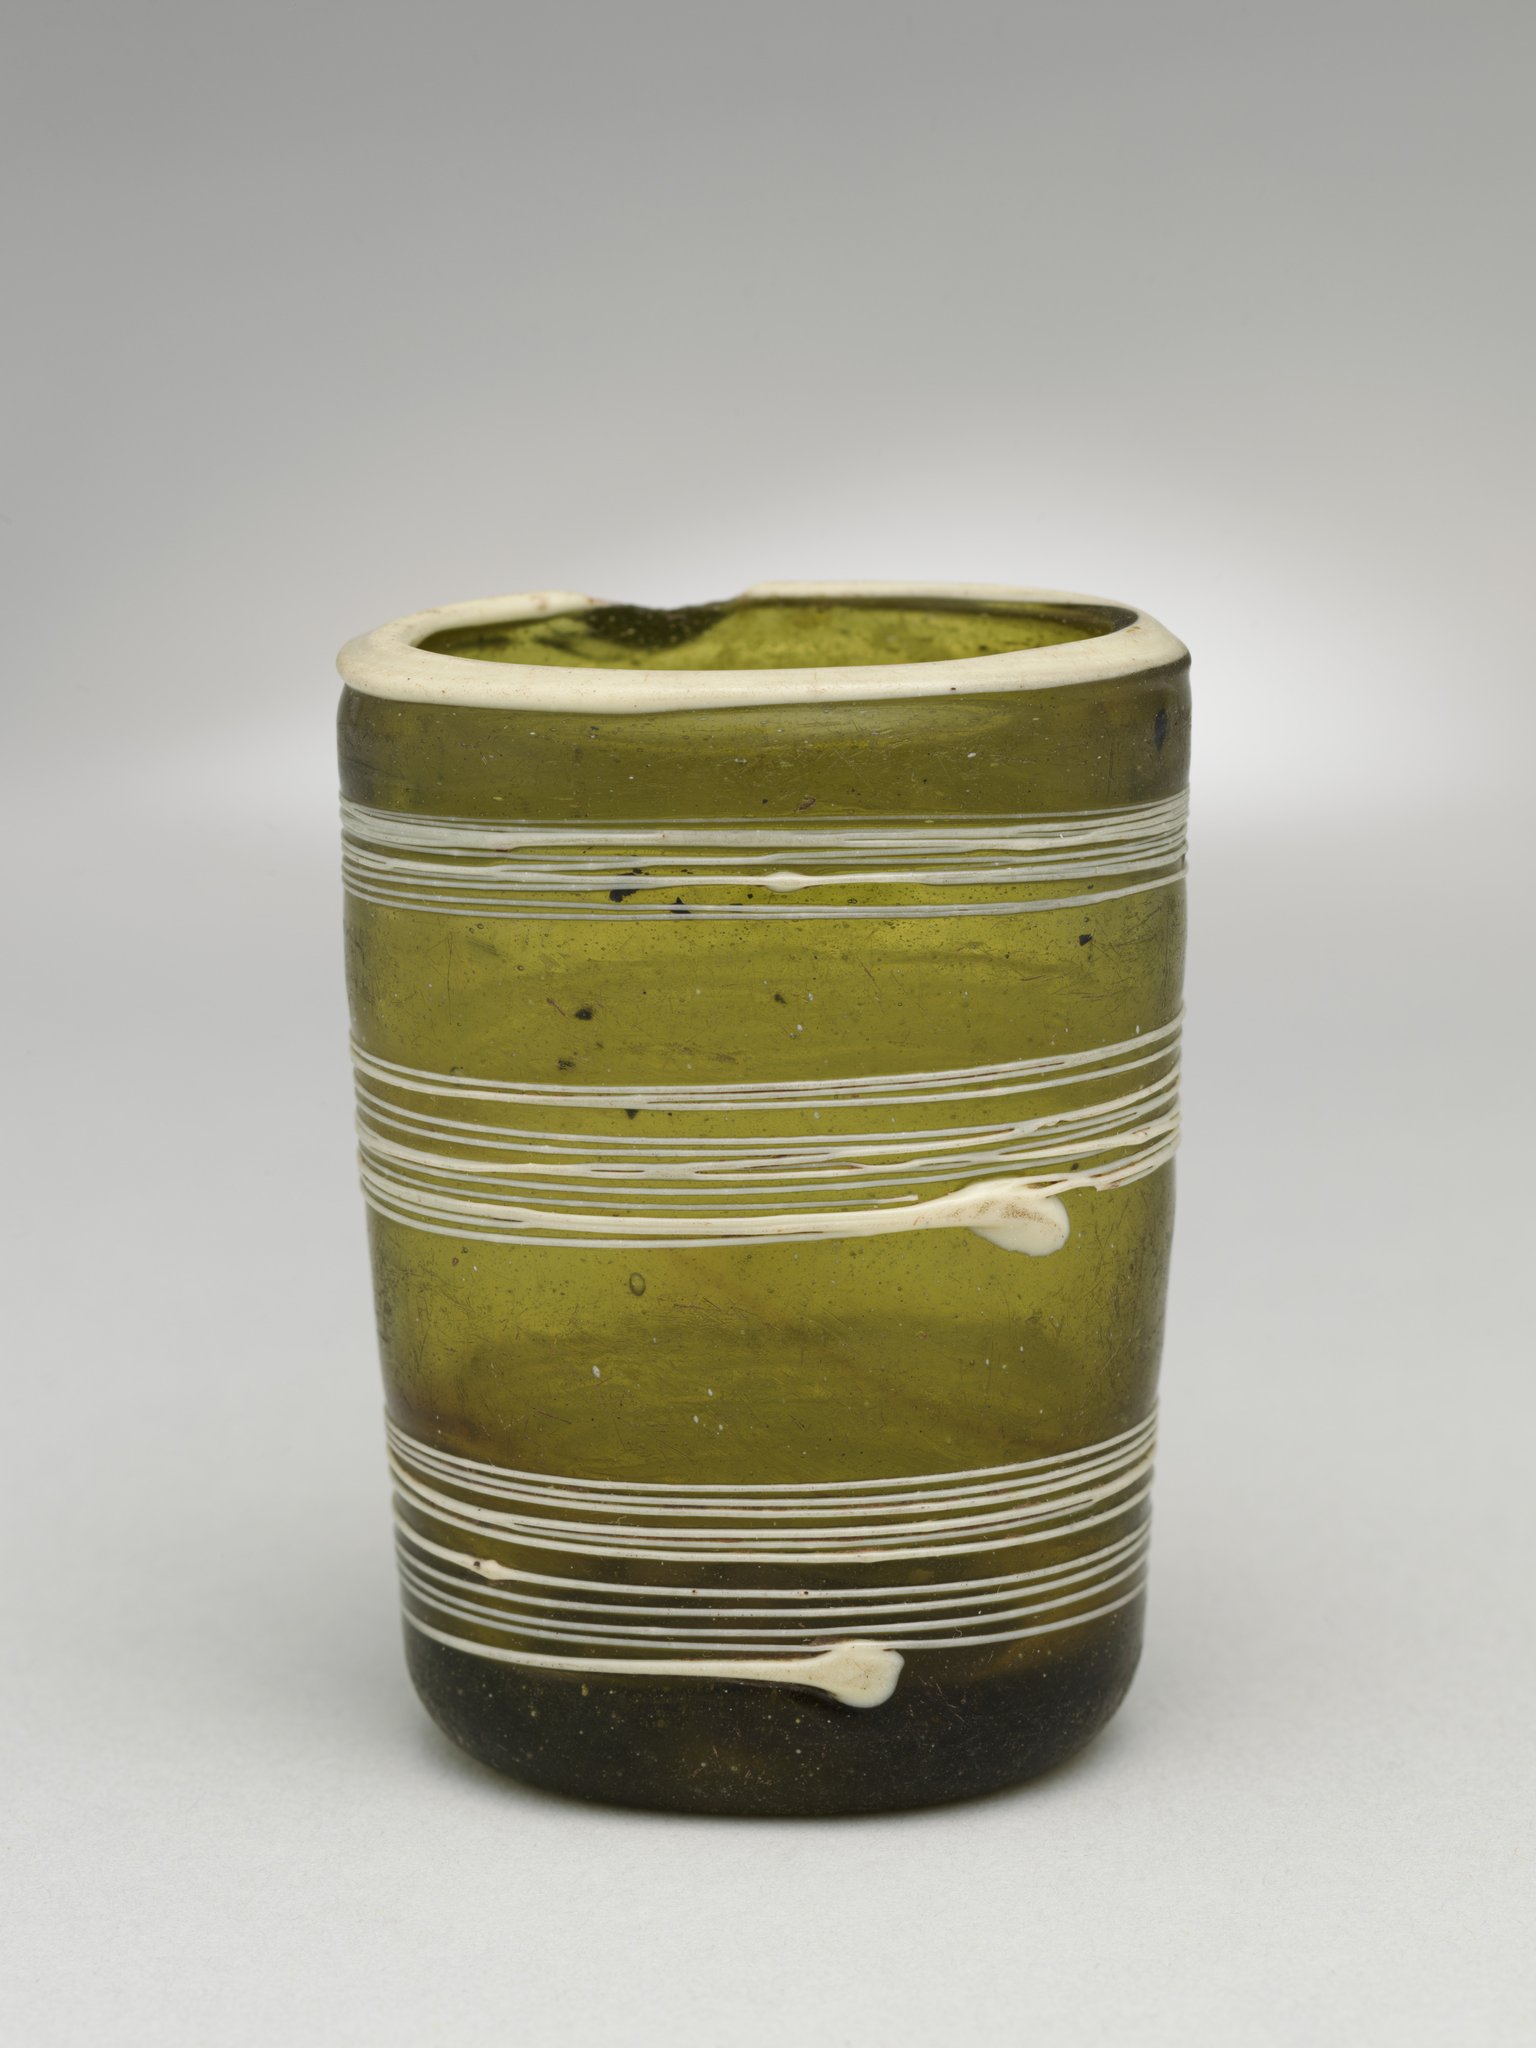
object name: beaker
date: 1701-1800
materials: glass